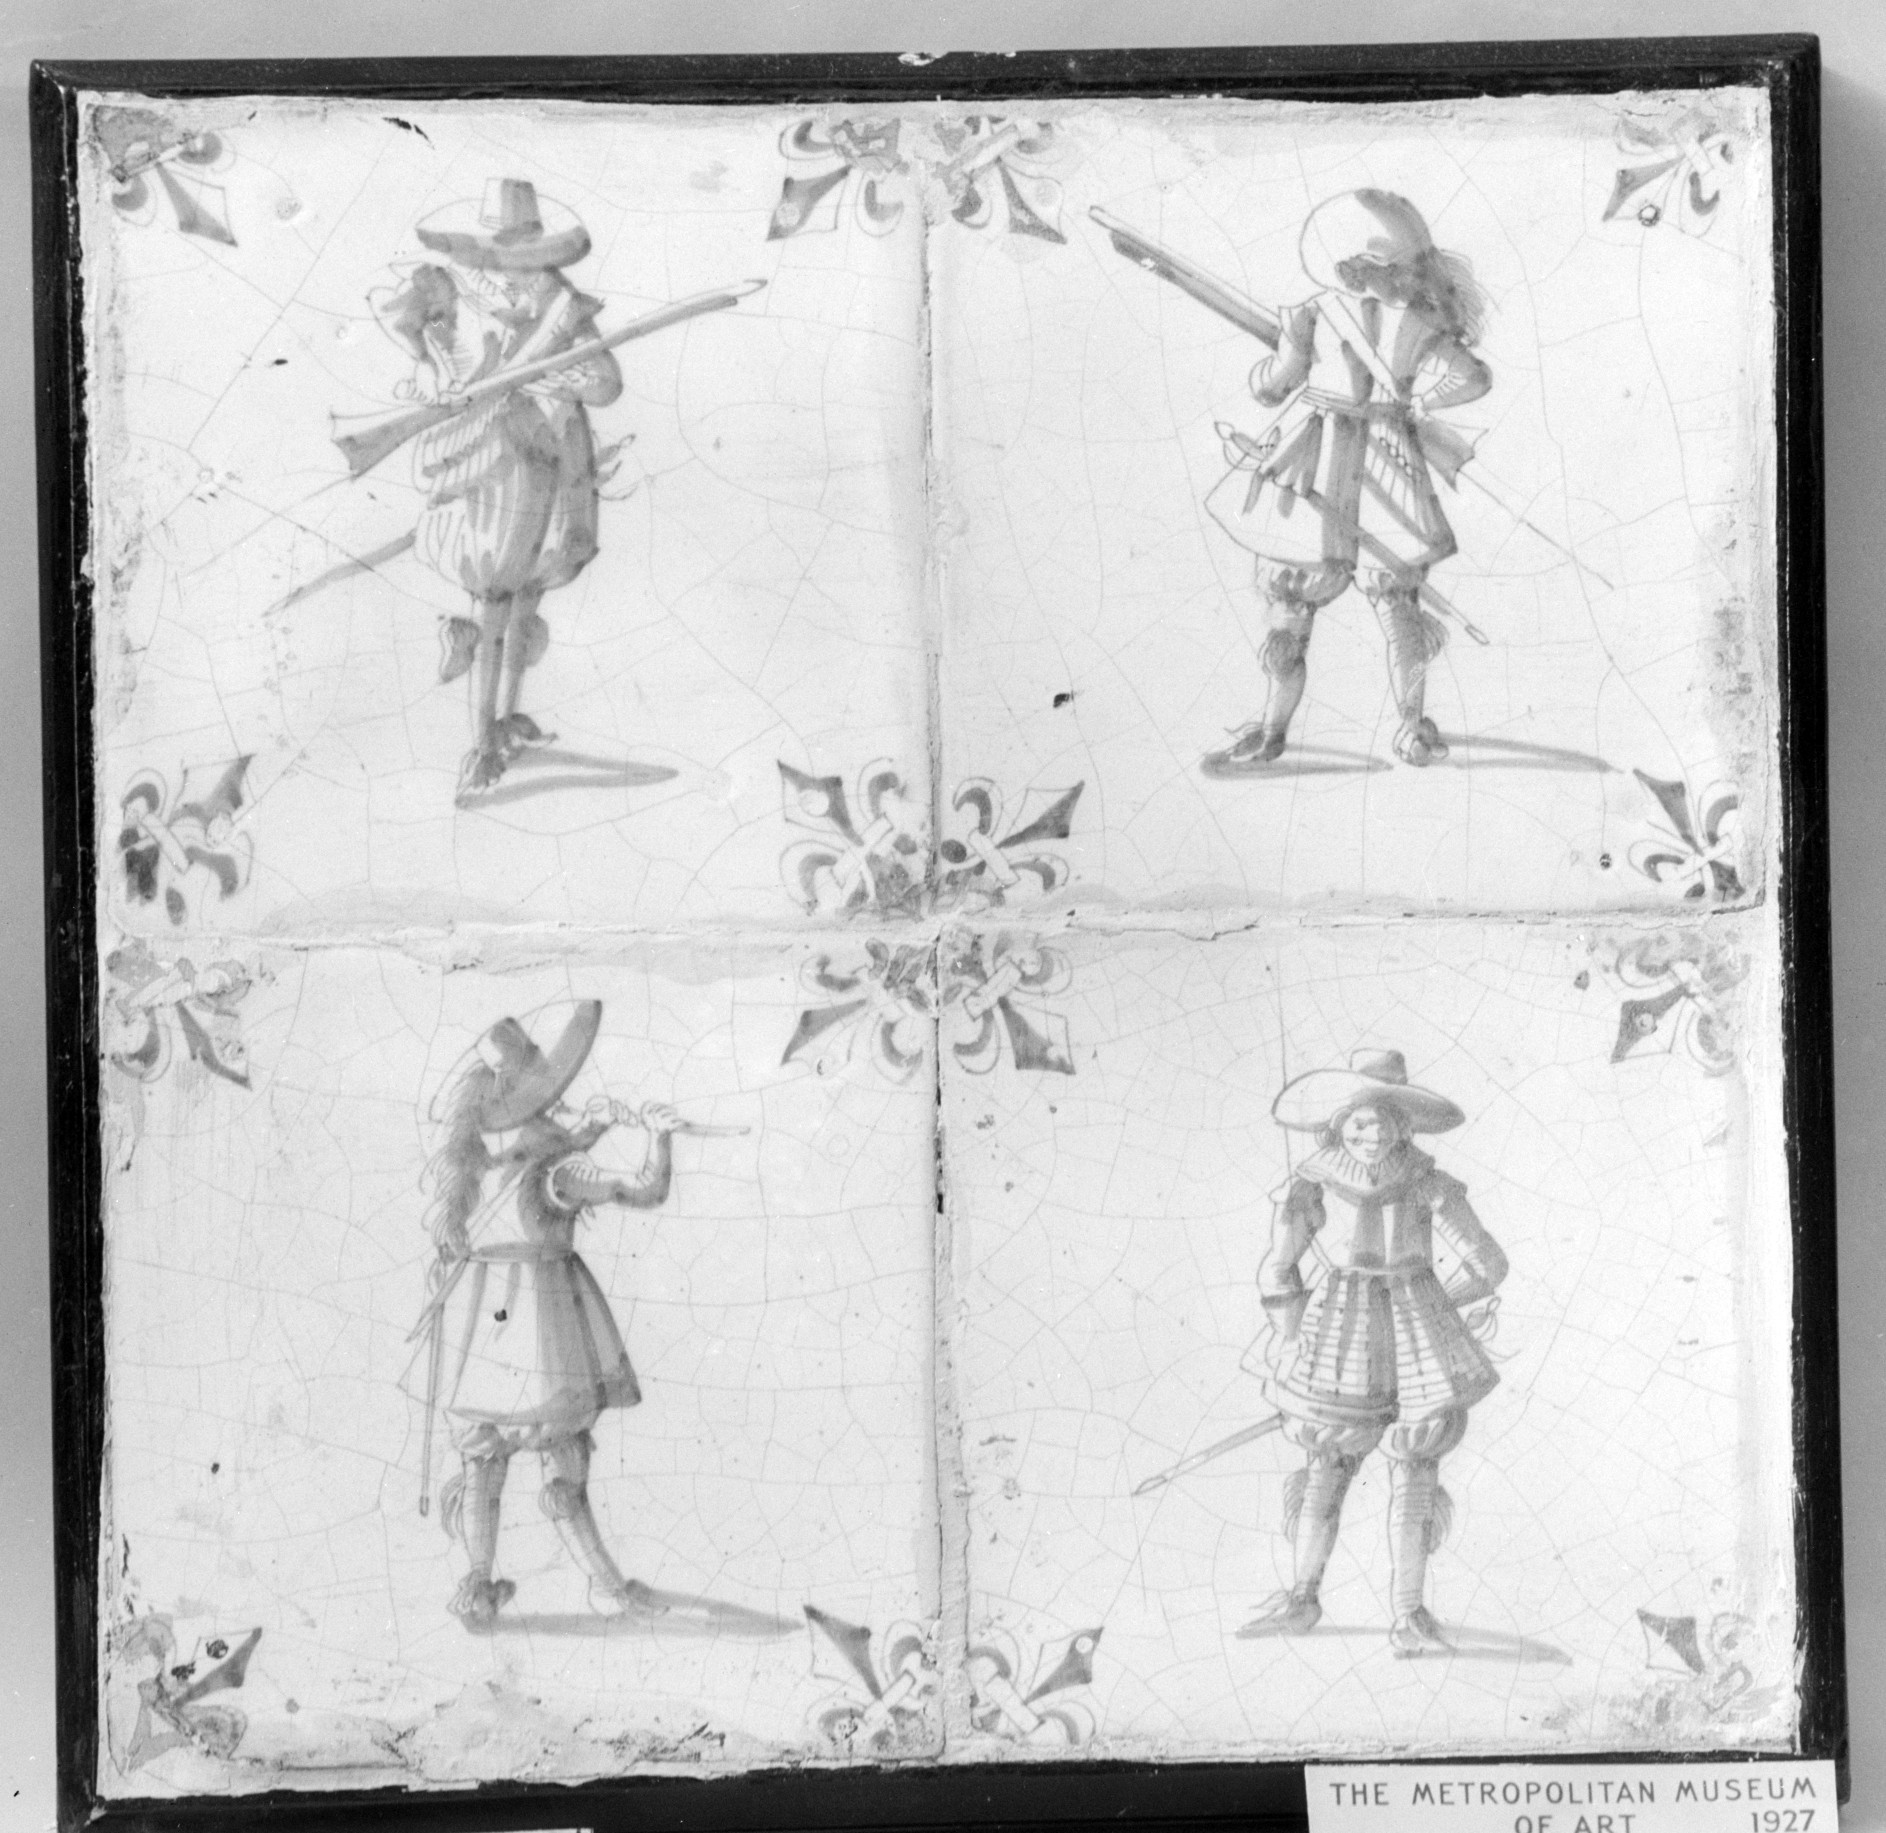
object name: tile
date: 1620-1650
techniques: glazing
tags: men